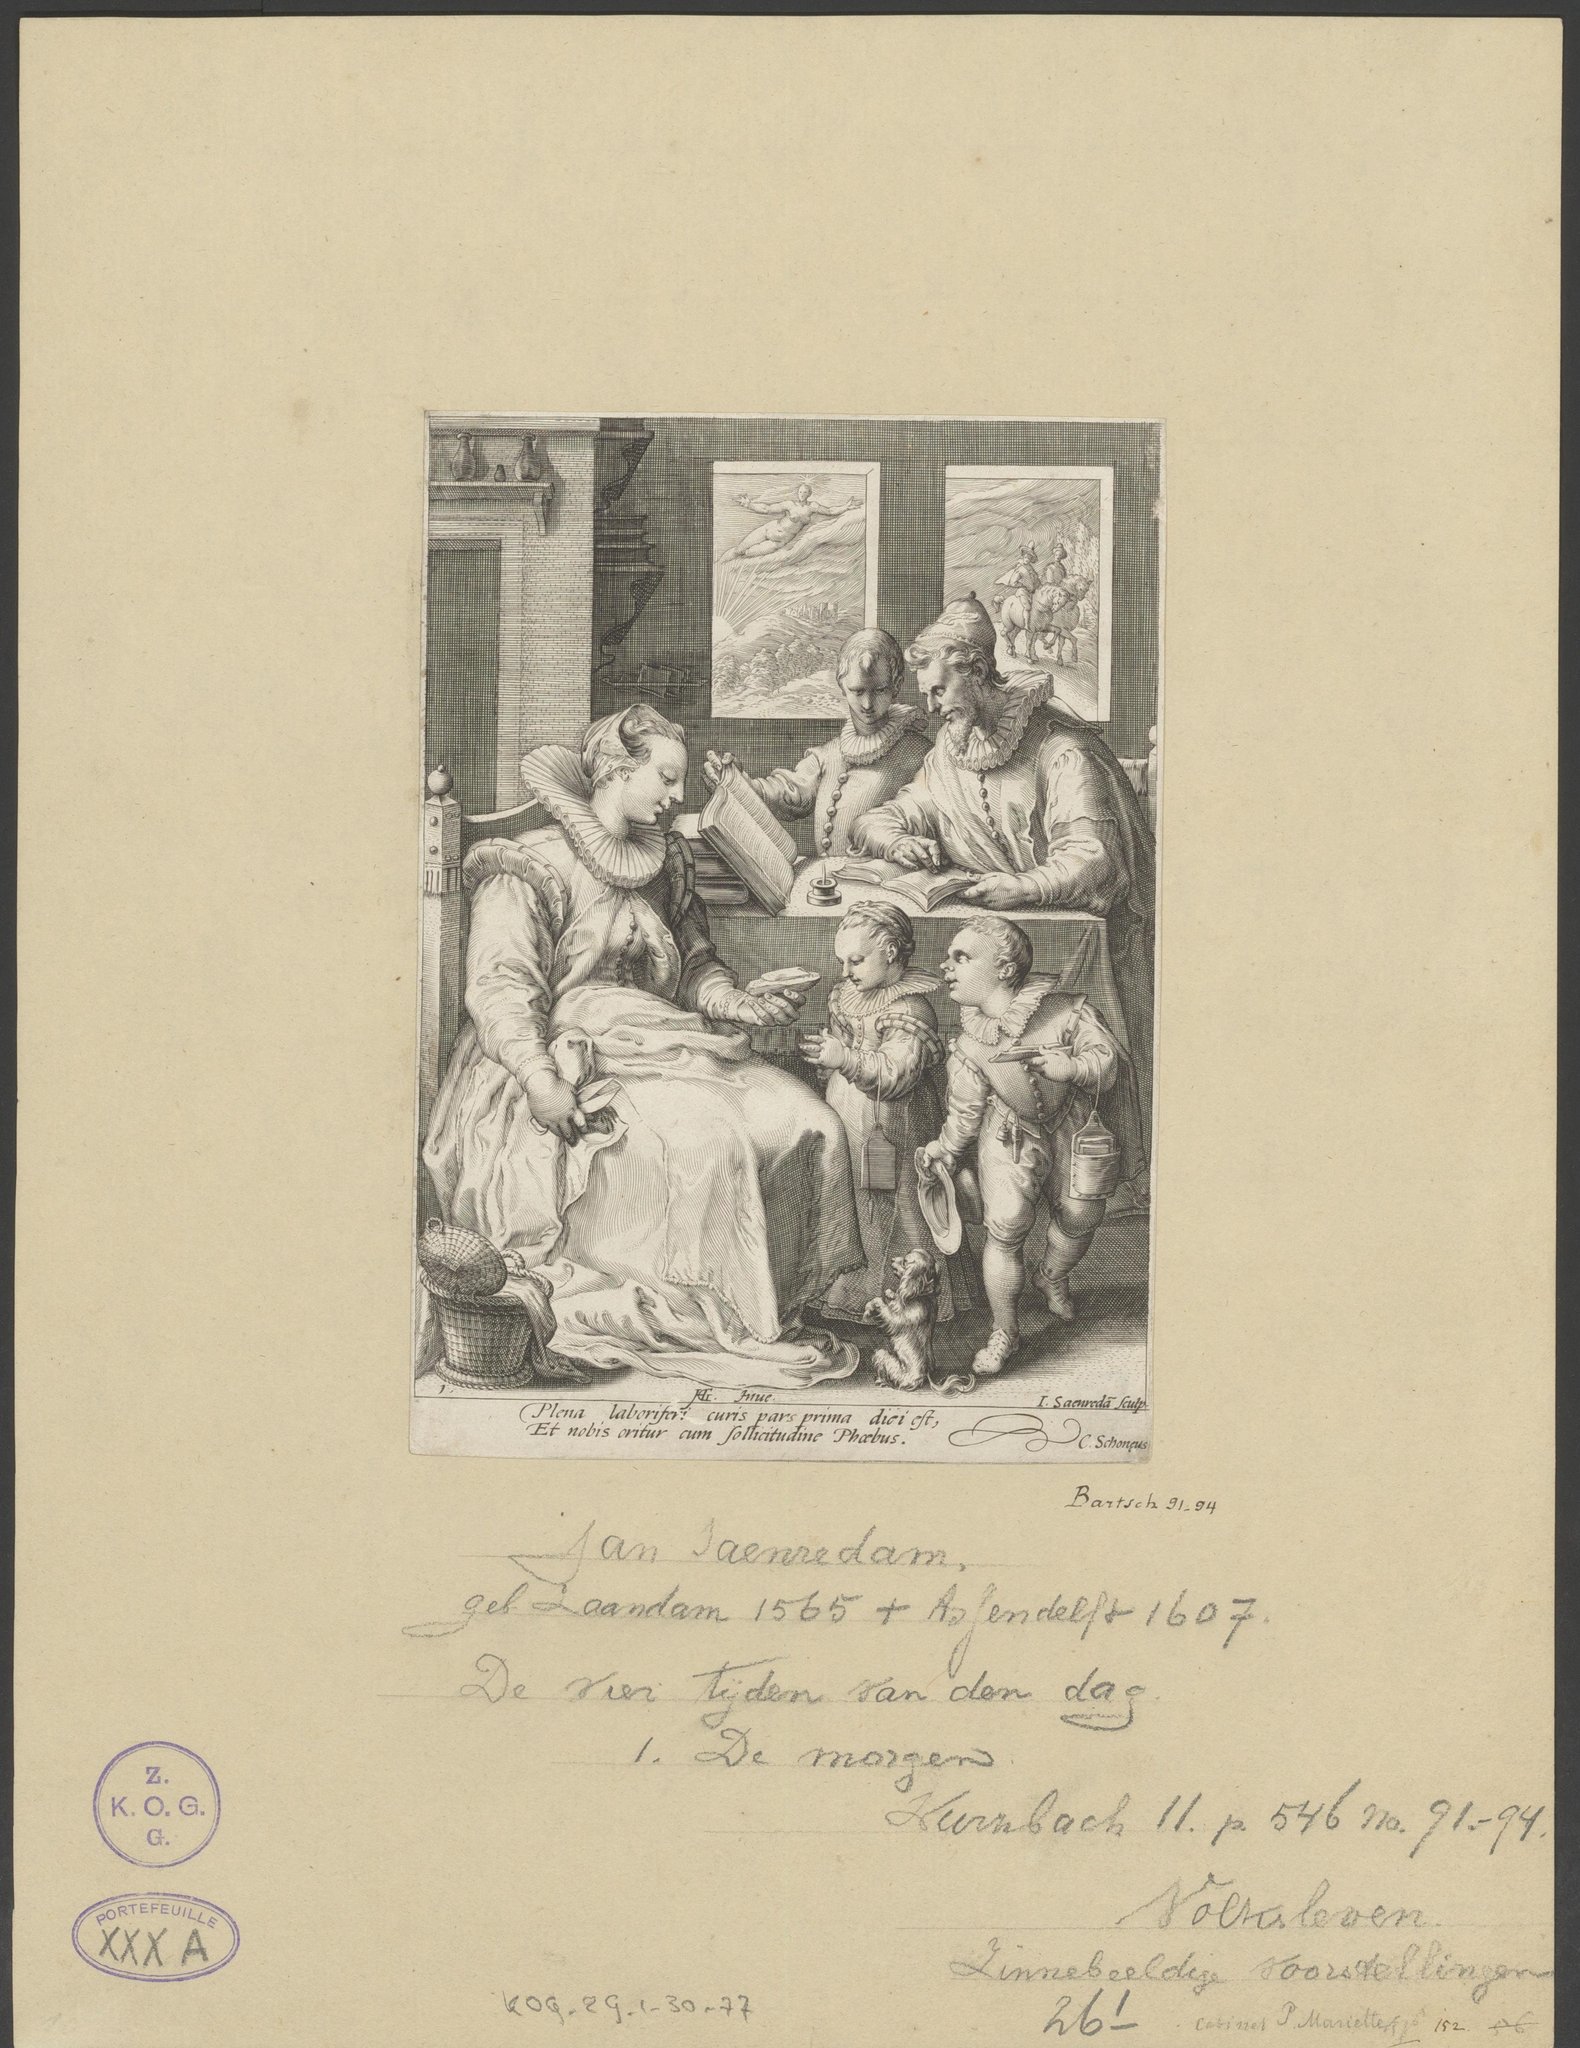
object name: print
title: Morgen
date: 1575-1607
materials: paper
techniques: engraving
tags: teacher and pupil, family life at home, taking care of children, morning ~ other concepts, tools, aids, implements ~ crafts and industries: scissors, personification of the morning, 'aurora'; 'aurora' (ripa), home sewing; repair of clothes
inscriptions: collector's mark: Lugt 963, collector's mark: Lugt 1641, stamp:, inscription: ‘P. mariette 1674’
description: In een vertrek zit een moeder met een schaar in haar hand op een stoel. Een naaimand staat naast haar op de grond. Ze geeft een van de twee kinderen die aan haar schoot staan een boterham. Het meisje houdt de handen gevouwen in gebed. Het tweede kind heeft een boterham in de hand. Bij beiden hangt de schoollei aan de arm. Een hondje zit in vragende houding op de grond. Achter hen staat de vader met de oudste zoon aan een tafel, waarop verschillende boeken en een inktpot. Door het venster is de opkomende zon en Aurora, de zuster van de zonnegod, te zien. Onderaan een tweeregelig vers in het Latijn. Rechtsonder genummerd: 1. Onderwerpsrubrieken binnen de Atlas Zeden en Gewoonten: Zeden en Gewoonten in engeren zin. Volksleven. Zinnebeeldige voorstellingen uit het volkleven op serieprenten. Maanden en diversen (allegorieën).